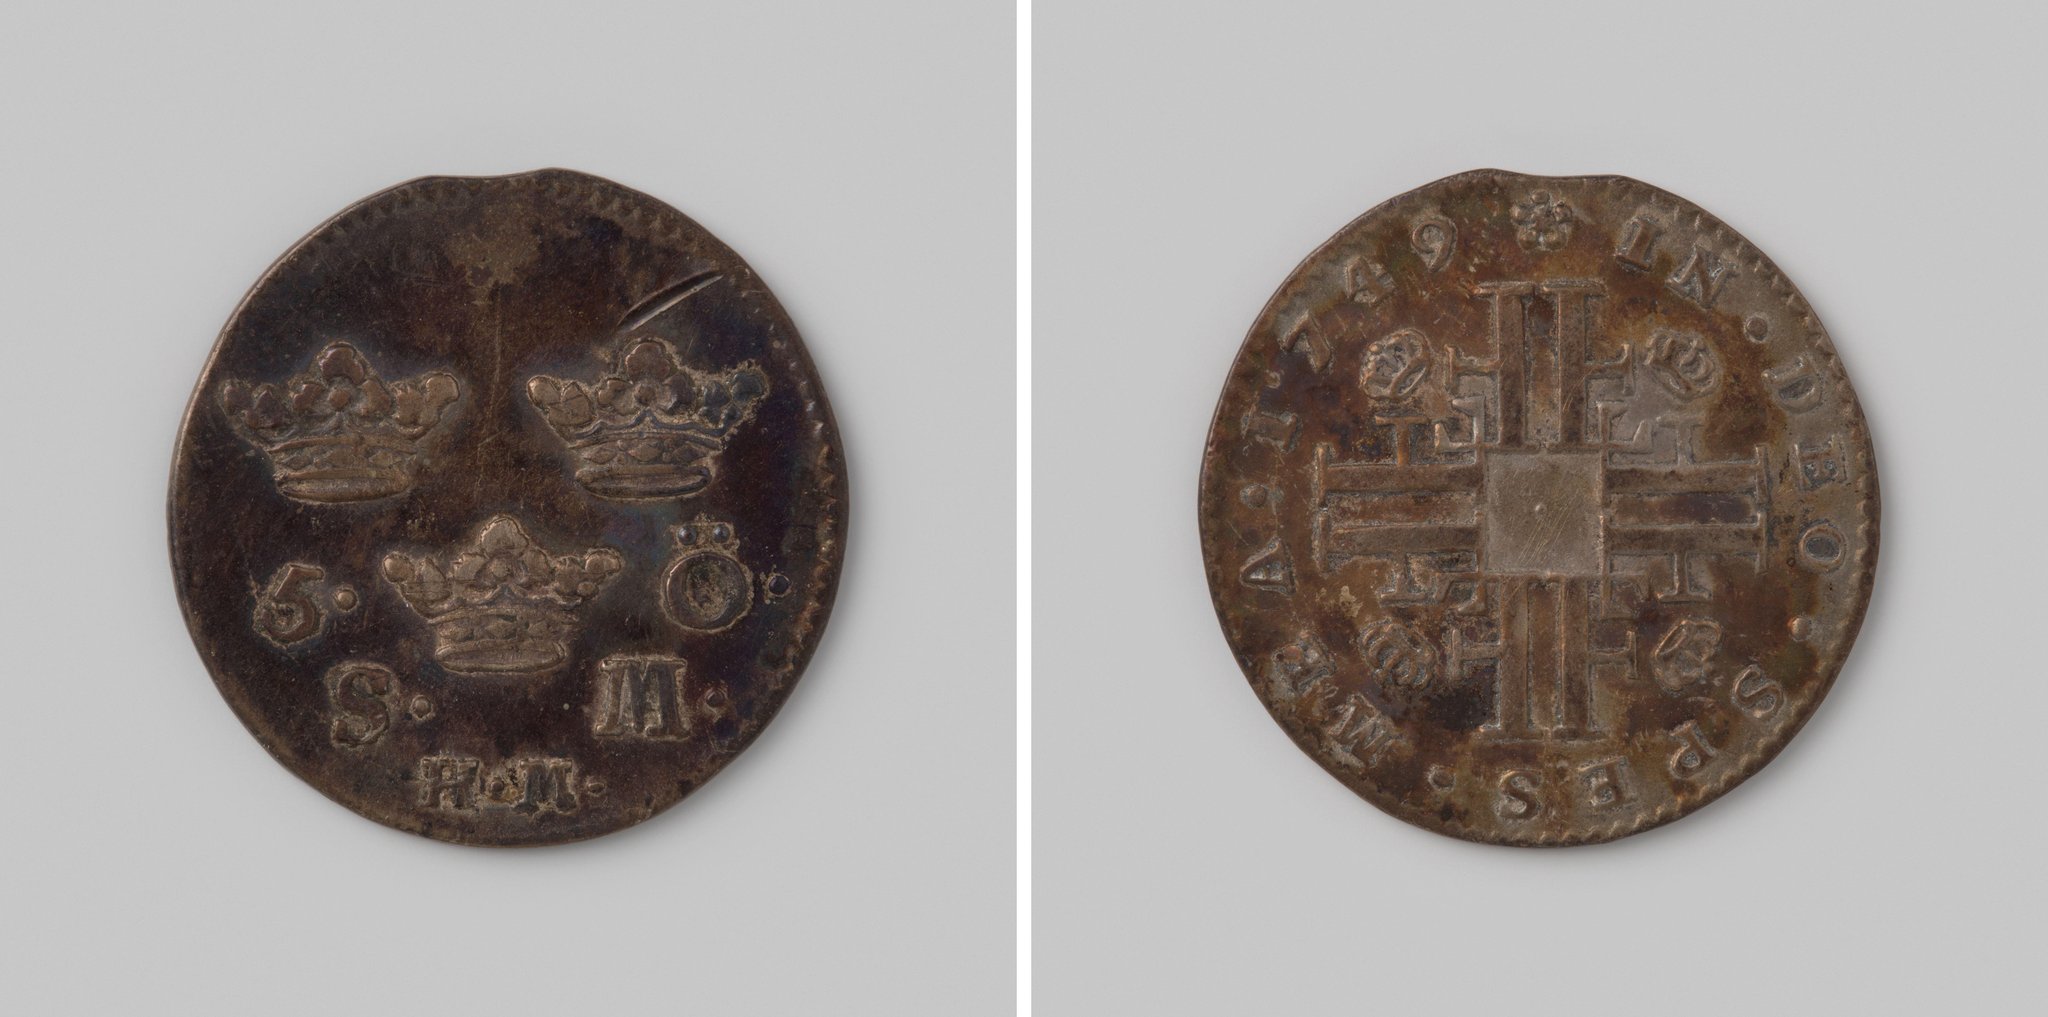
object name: coin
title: Zweden, Frederik I, 5 öre S[ilver] M[ynt],1737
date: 1737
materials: silver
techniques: striking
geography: slot rörstrand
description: Zilveren munt. Voorzijde: drie kronen. Waarde-aanduiding in twee regels in veld. Keerzijde: kruis, waarbij elk been uit tweee van elkaar afgewende letters F bestaat. In de hoeken koningskronen. Jaartal in omschrift. Gladde rand.